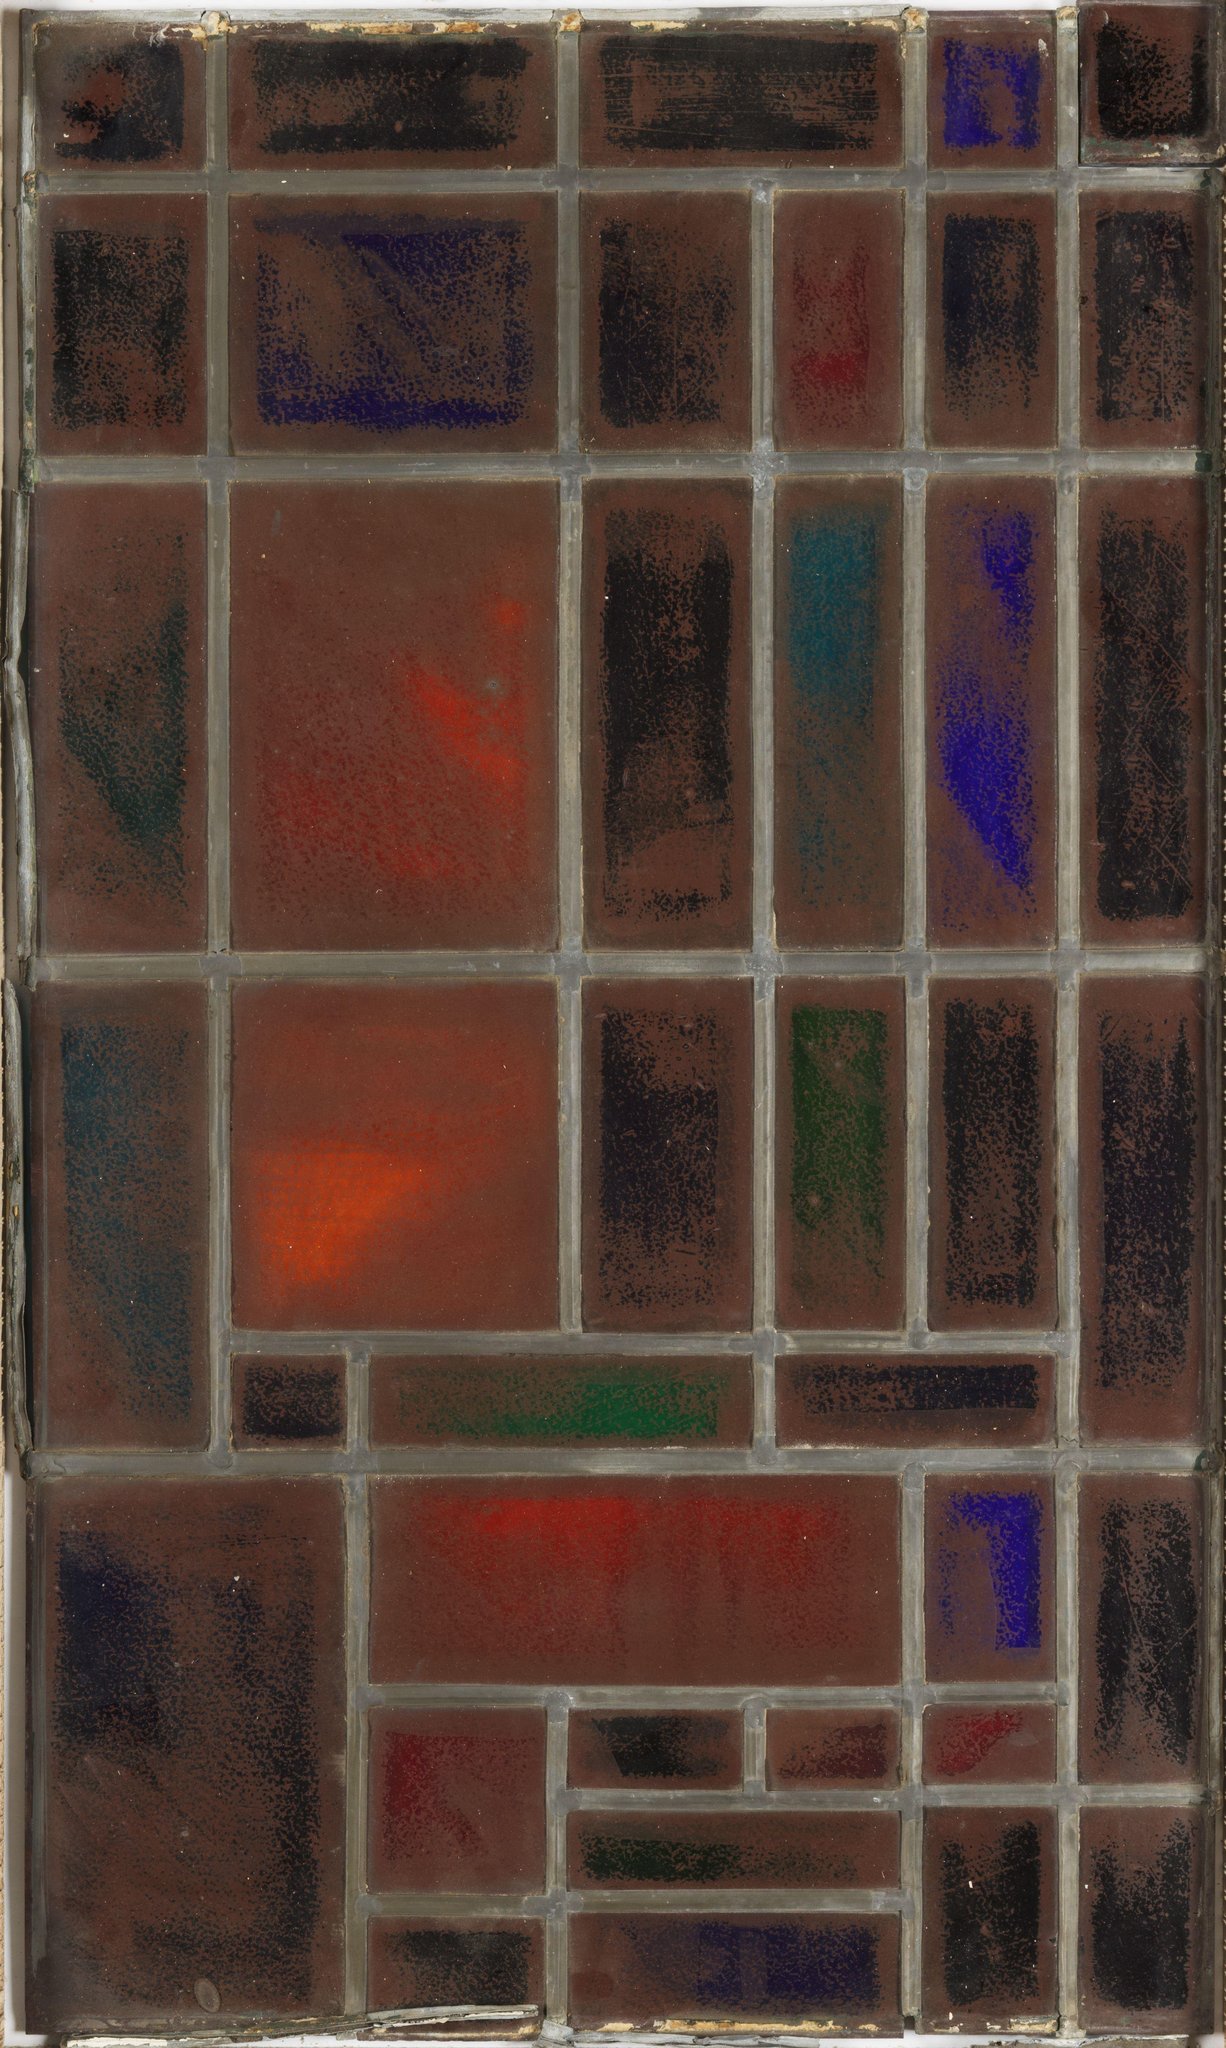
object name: light window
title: Glas-in-lood, vak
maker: Anonymous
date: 1940-1970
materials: glass, lead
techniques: leading